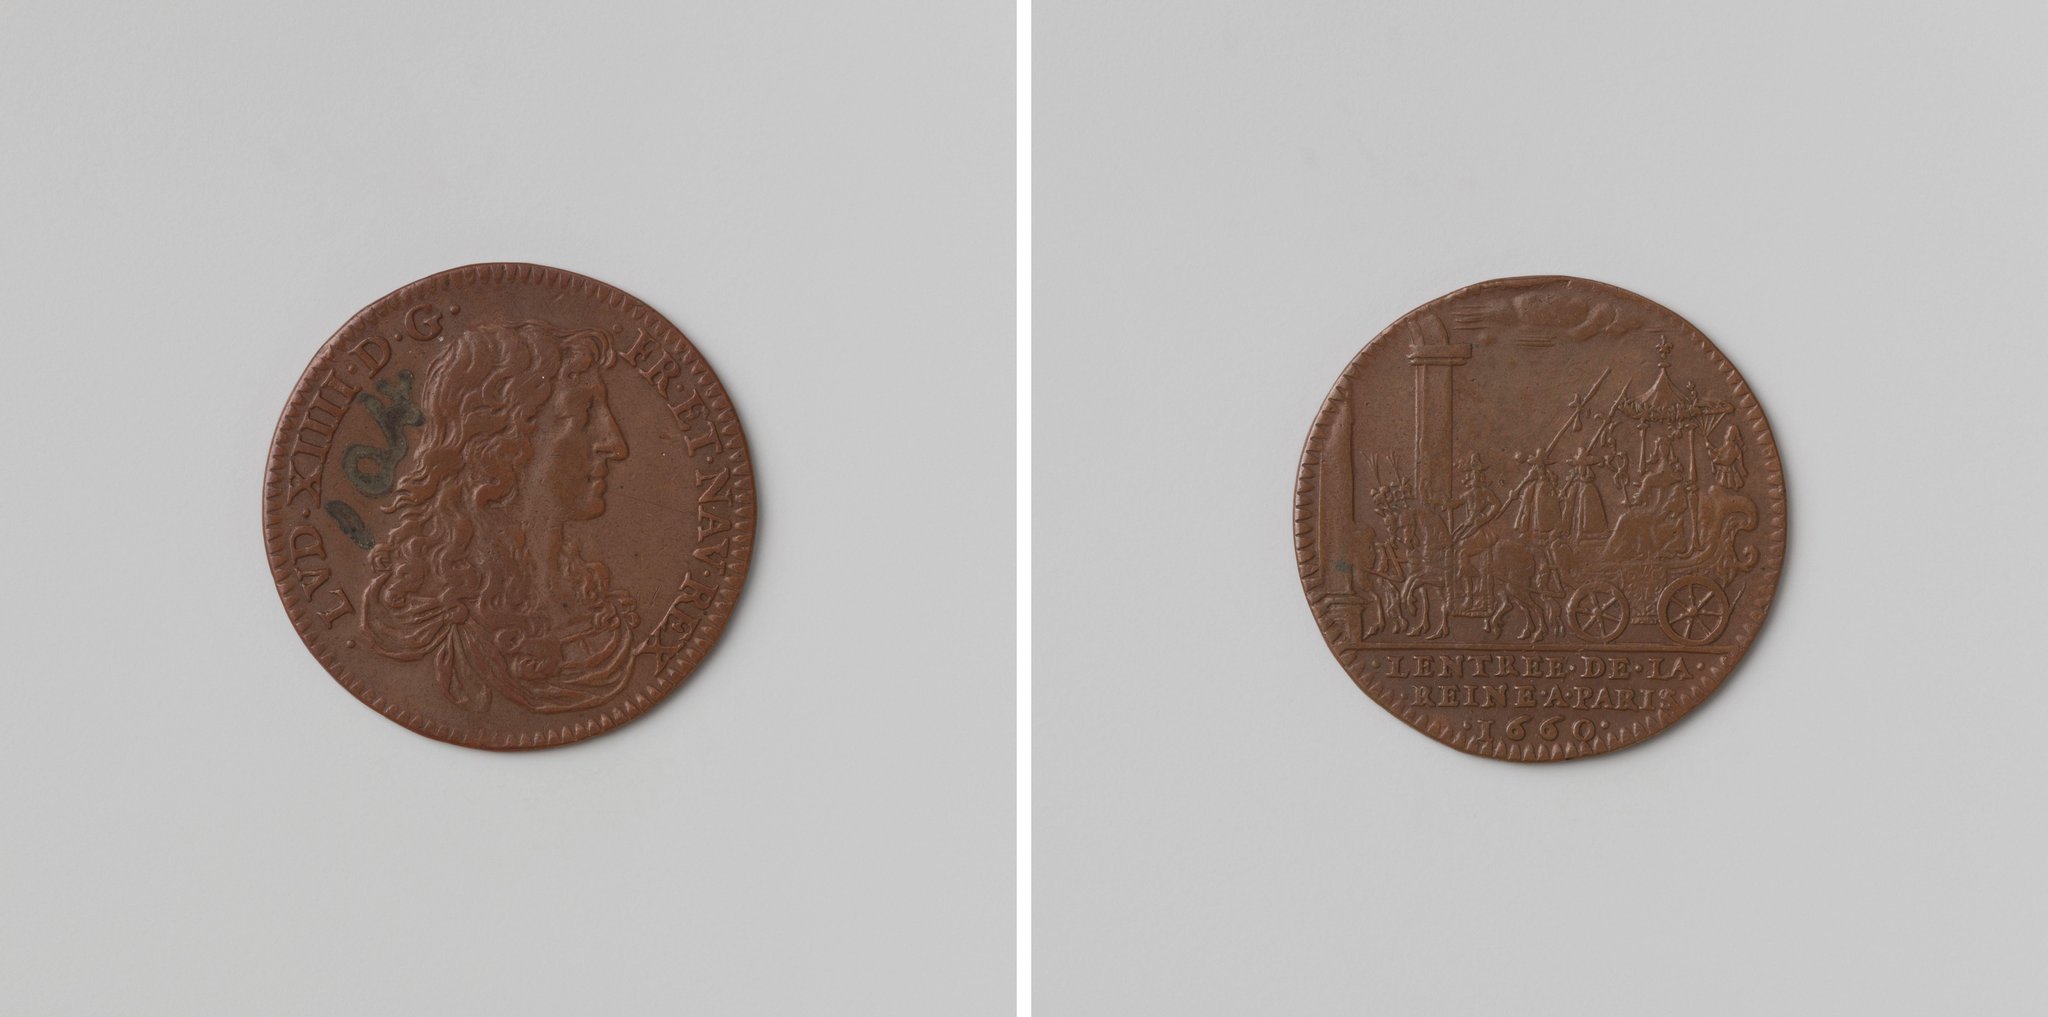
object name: jeton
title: Aankomst van Maria Theresia in Parijs, rekenpenning geslagen ter ere van Lodewijk XIV, koning van Frankrijk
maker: Anonymous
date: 1660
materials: copper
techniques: striking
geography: france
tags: lodewijk xiv (koning van frankrijk), maria theresia (koningin van frankrijk), paris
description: Koperen penning. Voorzijde: borststuk man binnen omschrift. Keerzijde: koningin op zegewagen; afsnede: opschrift